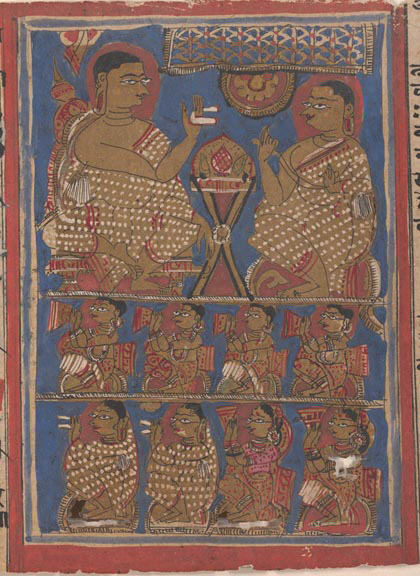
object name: folio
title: Mahavira Preaching the Samacari (top) / Part of Mahavira's Audience as He Preached the Samacari (bottom); Page from a Dispersed Kalpa Sutra (Jain Book of Rituals)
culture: indian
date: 1401-1500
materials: gold, ink, paper, watercolor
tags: men,women